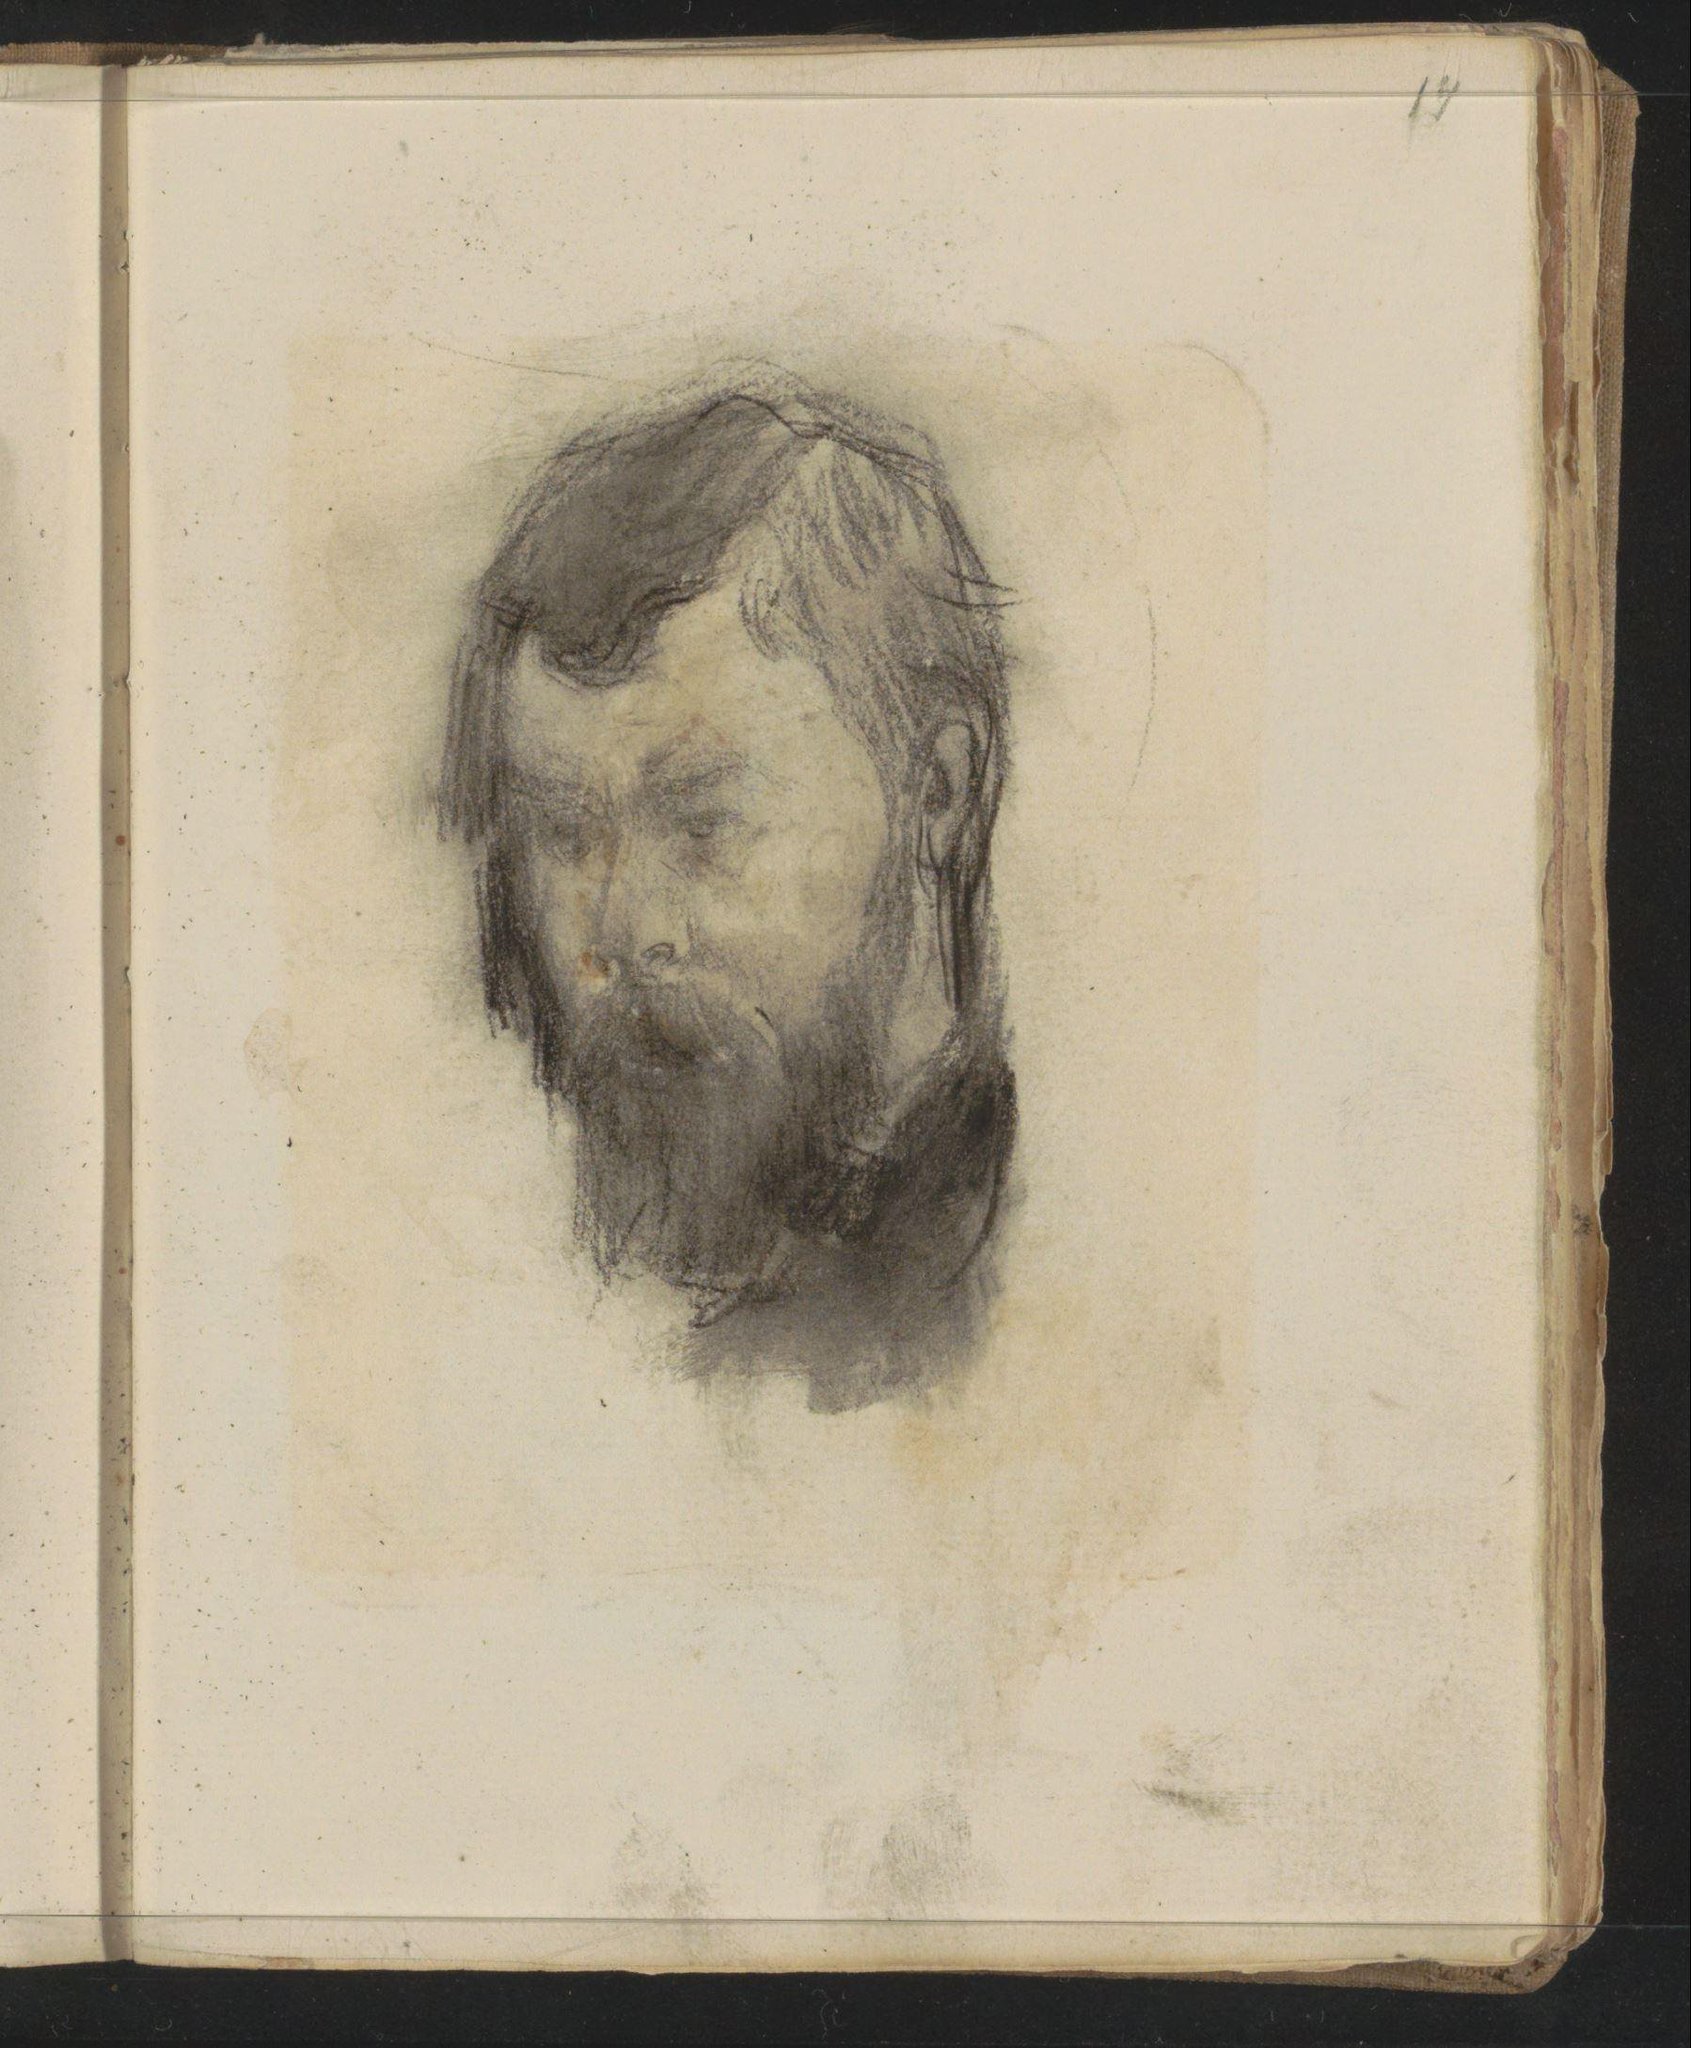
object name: sketchbook leaf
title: Mansportret, mogelijk kunstenaar Jan Toorop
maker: floris arntzenius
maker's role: draughtsman, print maker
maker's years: 1864-1925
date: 1883-1914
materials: chalk, paper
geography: the hague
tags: the hague, painter, print maker, draughtsman, jan toorop, portrait, self-portrait of artist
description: Pagina 14 uit een schetsboek met 82 pagina's.